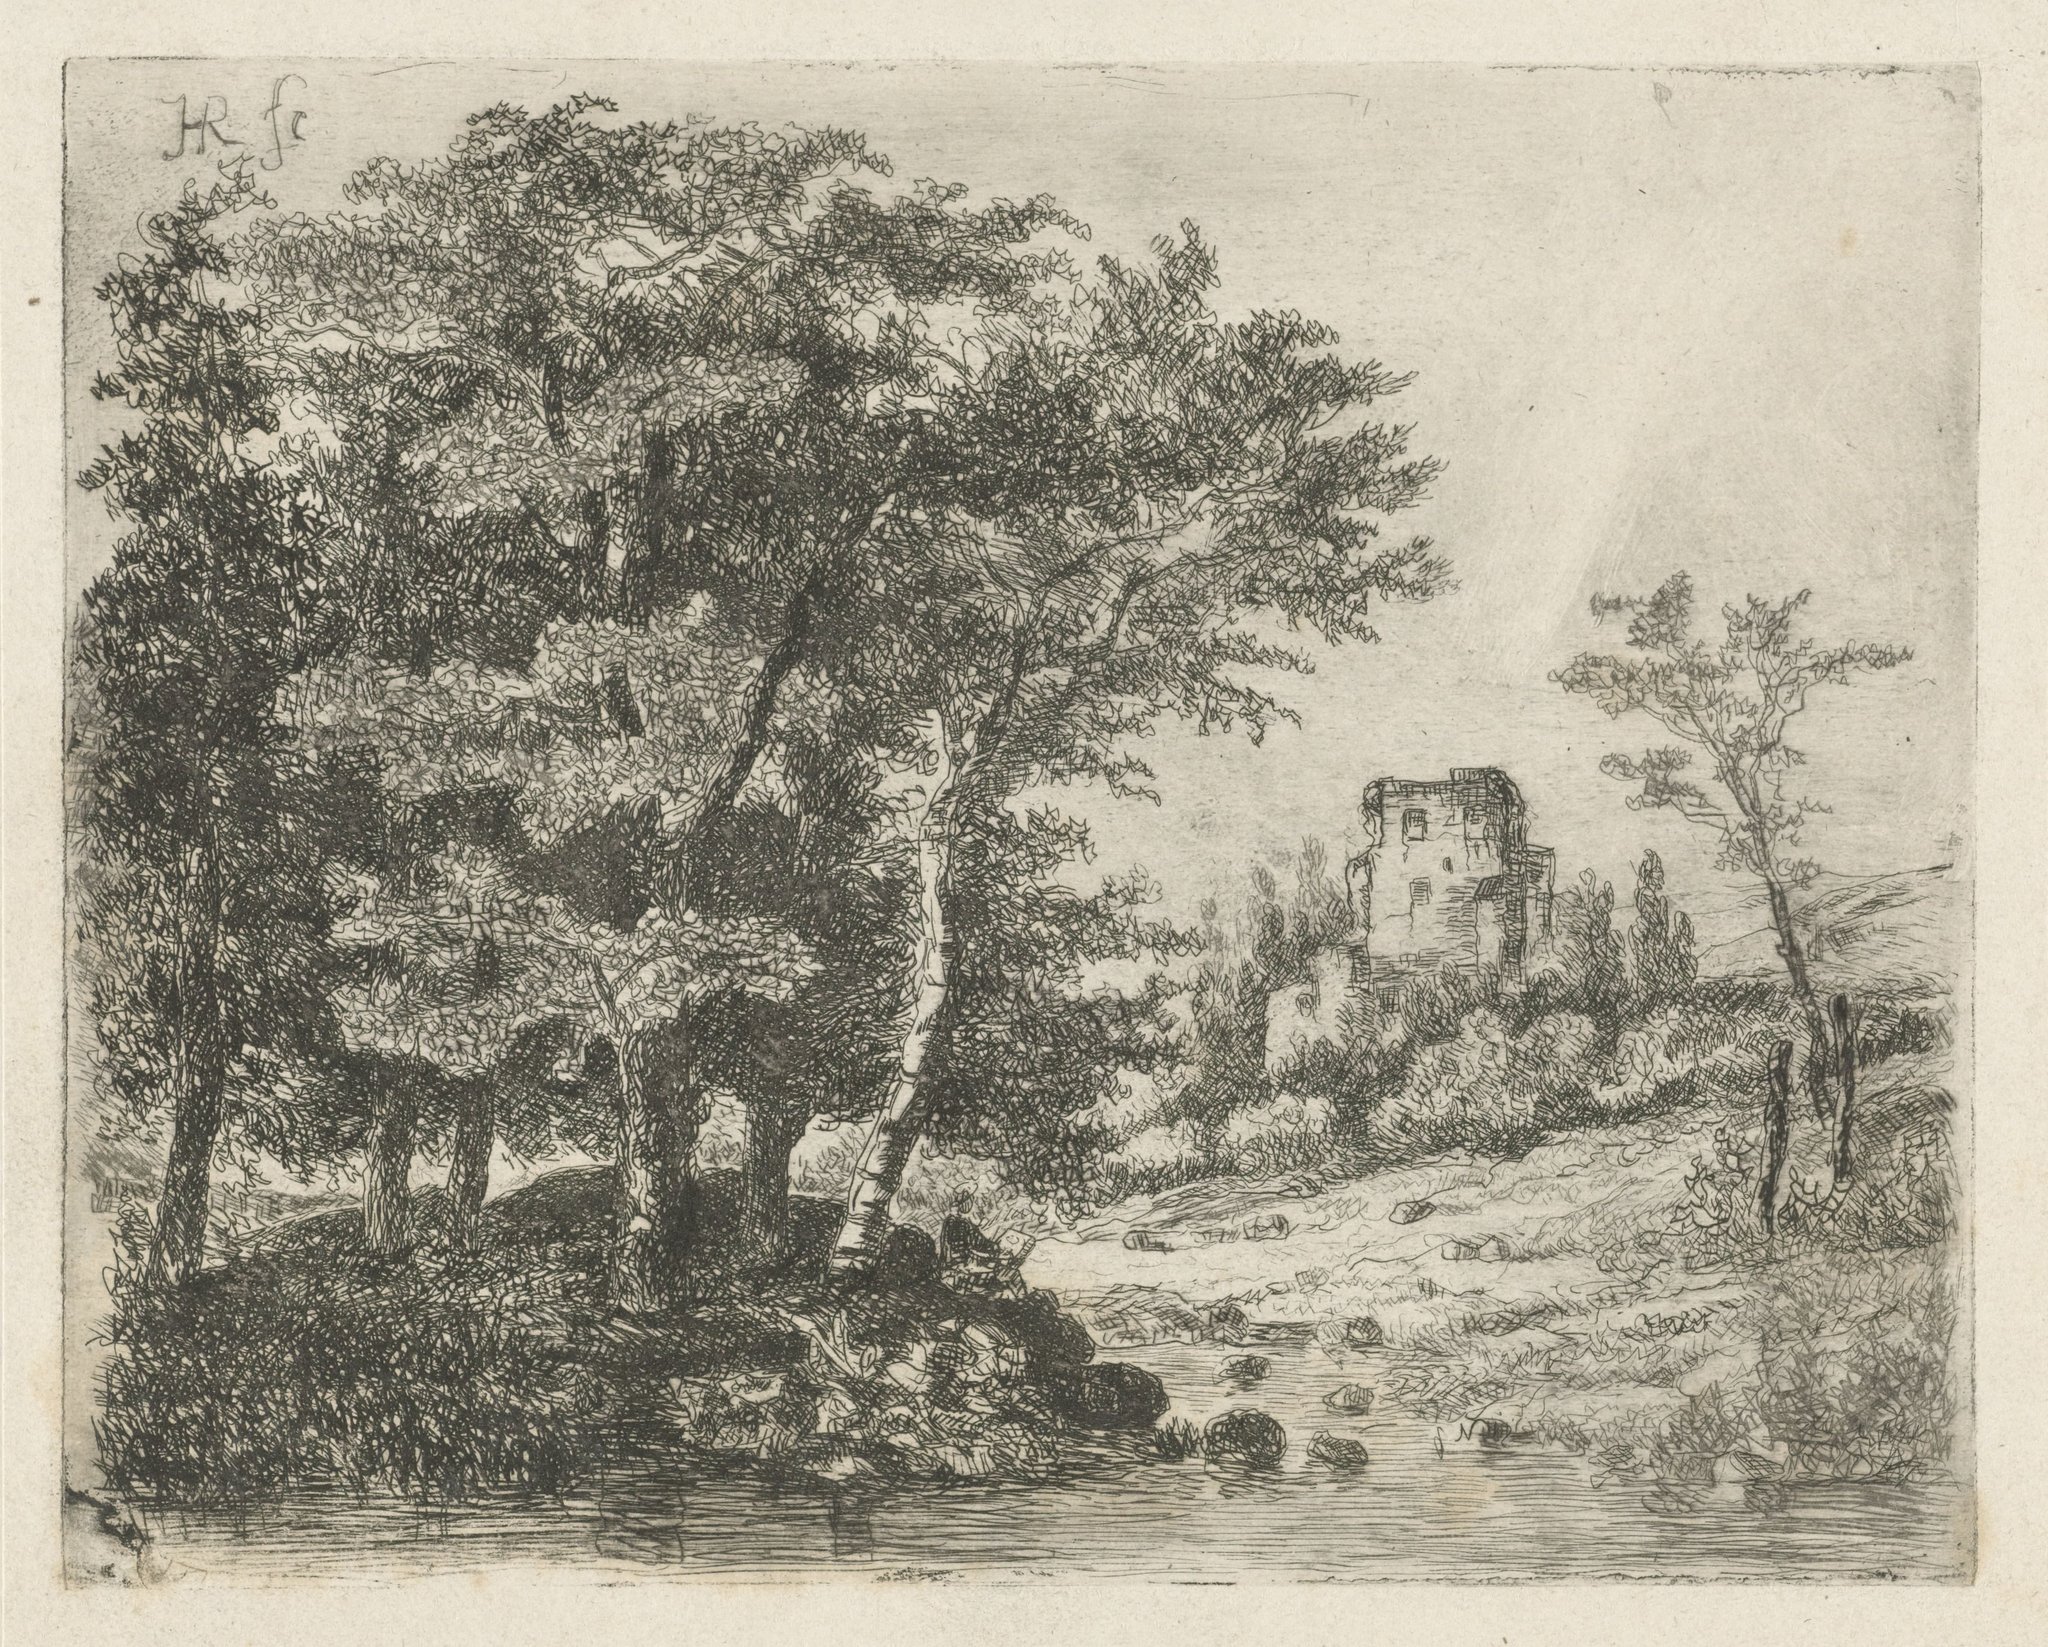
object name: print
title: Ruïne in een landschap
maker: hermanus jan hendrik van rijkelijkhuysen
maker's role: painter, print maker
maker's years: 1813-1883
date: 1823-1883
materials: paper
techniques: drypoint, etching, intaglio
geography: utrecht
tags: island, trees, landscape with ruins, brook, draughtsman at work - cc - out of doors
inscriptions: collector's mark: Lugt 2228, collector's mark: Lugt 1485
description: Gezicht op een landschap met een, aan een stroom gelegen, ruïne. In het water ligt een boomrijk eiland, waar een man zit te tekenen.